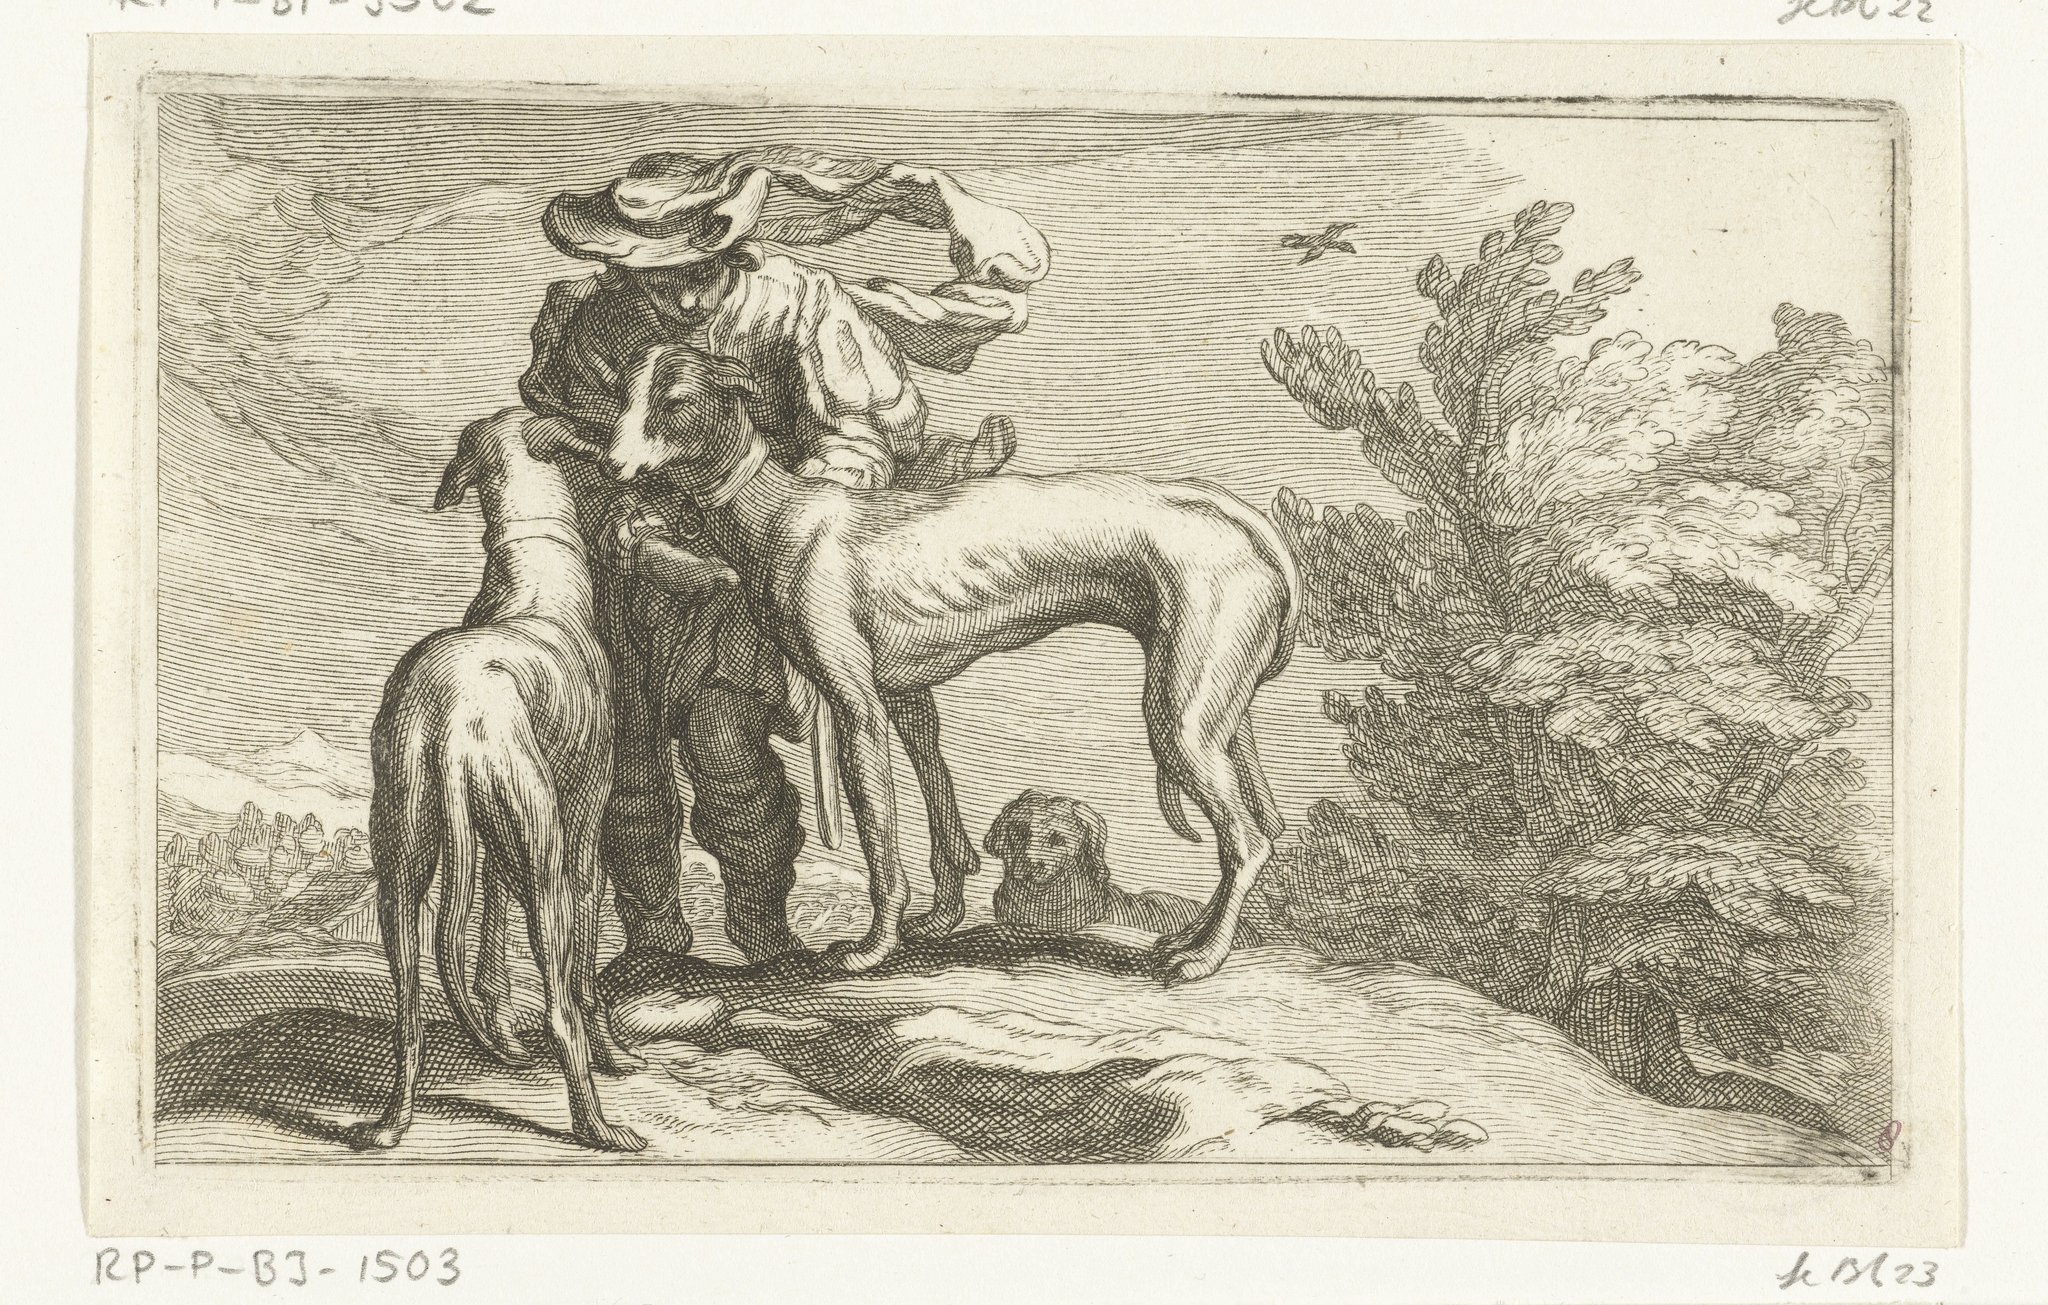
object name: print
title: Dieren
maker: frederick bloemaert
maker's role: print maker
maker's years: 1614-1669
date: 1635-1670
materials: paper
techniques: engraving, etching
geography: utrecht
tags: dog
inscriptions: collector's mark: Lugt 240, number: ‘8’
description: Een jongen staat tussen twee windhonden op een heuvel. Prent uit een serie van 14 prenten met verschillende inheemse dieren.